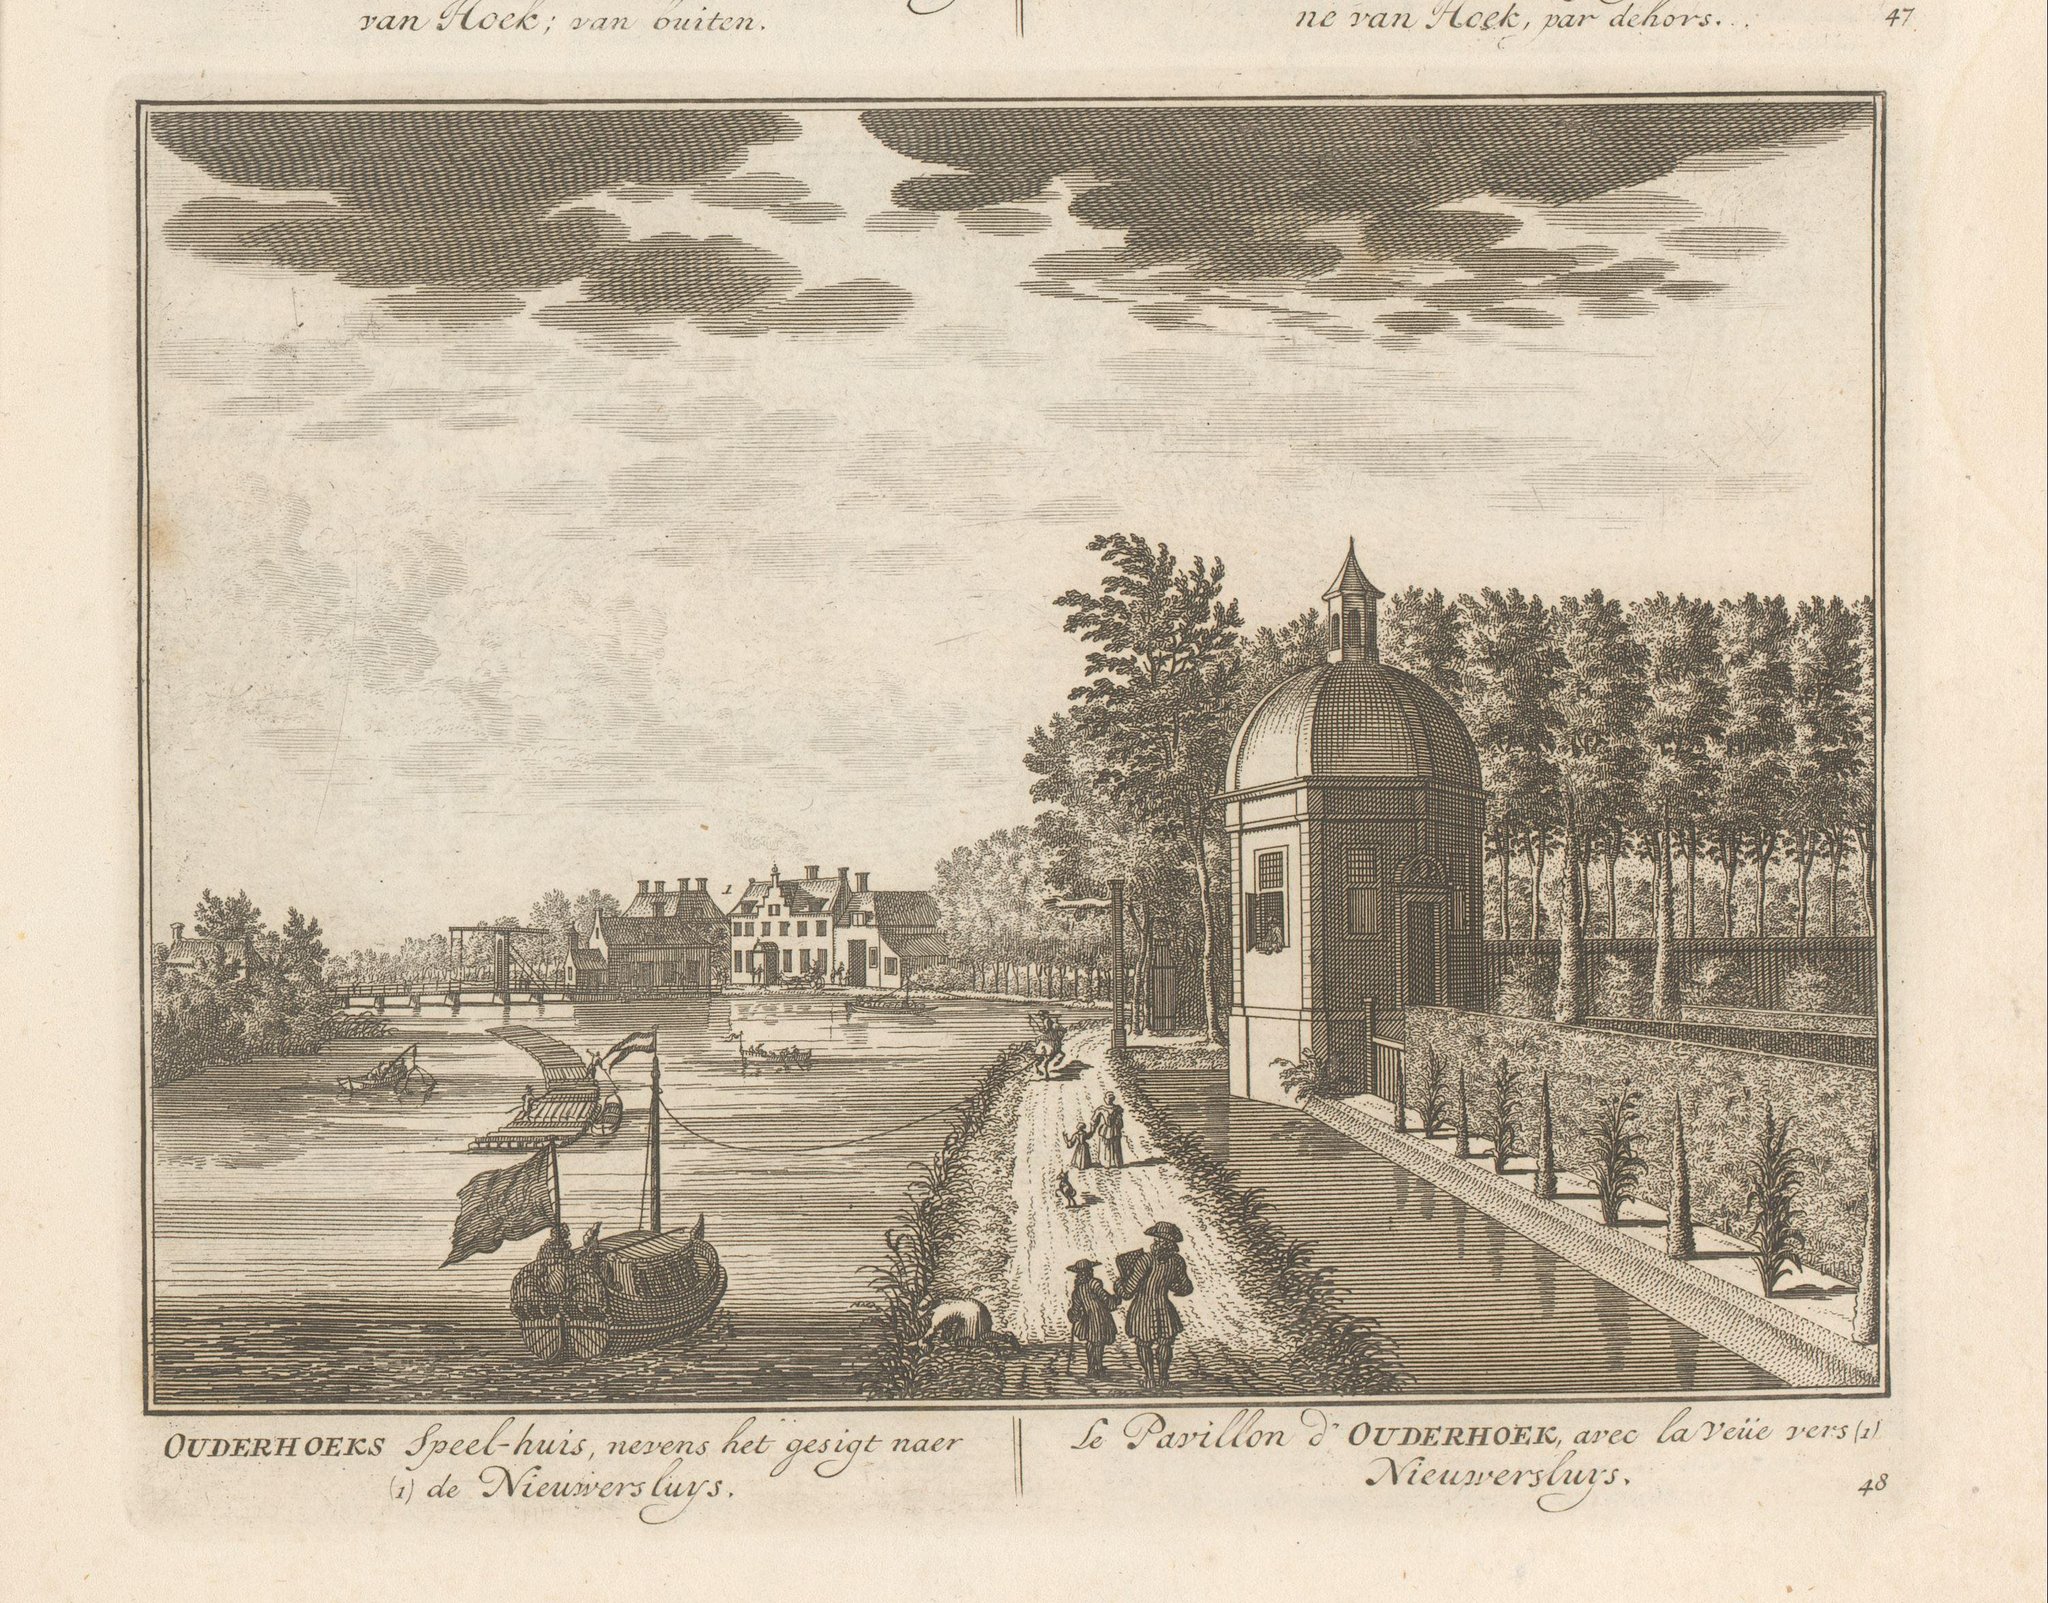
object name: book illustration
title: Ouderhoeks Speel-huis, nevens het gesigt naer (1) de Nieuwersluys / Le Pavillon d'Ouderhoek, avec la veiie vers (1) Nieuwersluys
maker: daniël stopendaal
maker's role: print maker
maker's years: 1672-1726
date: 1790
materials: paper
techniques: engraving, etching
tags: river (+ landscape with figures, staffage), country-house, vecht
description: Prent gebruikt in: Leth, Andries de. De zegepraalende Vecht, vertoonende verscheidene gesichten van lustplaatsen, heeren huysen en dorpen, beginnende van Uitrecht en met Muyden besluytende (...). Amsterdam: Weduwe Nicolaus Visscher, 1719. Prent ook gebruikt in: Brouërius van Nidek, Matthaeus. De Vechtstroom, van Utrecht tot Muiden (...). Amsterdam: H. Gartman, W. Vermandel en J.W. Smit, 1790.